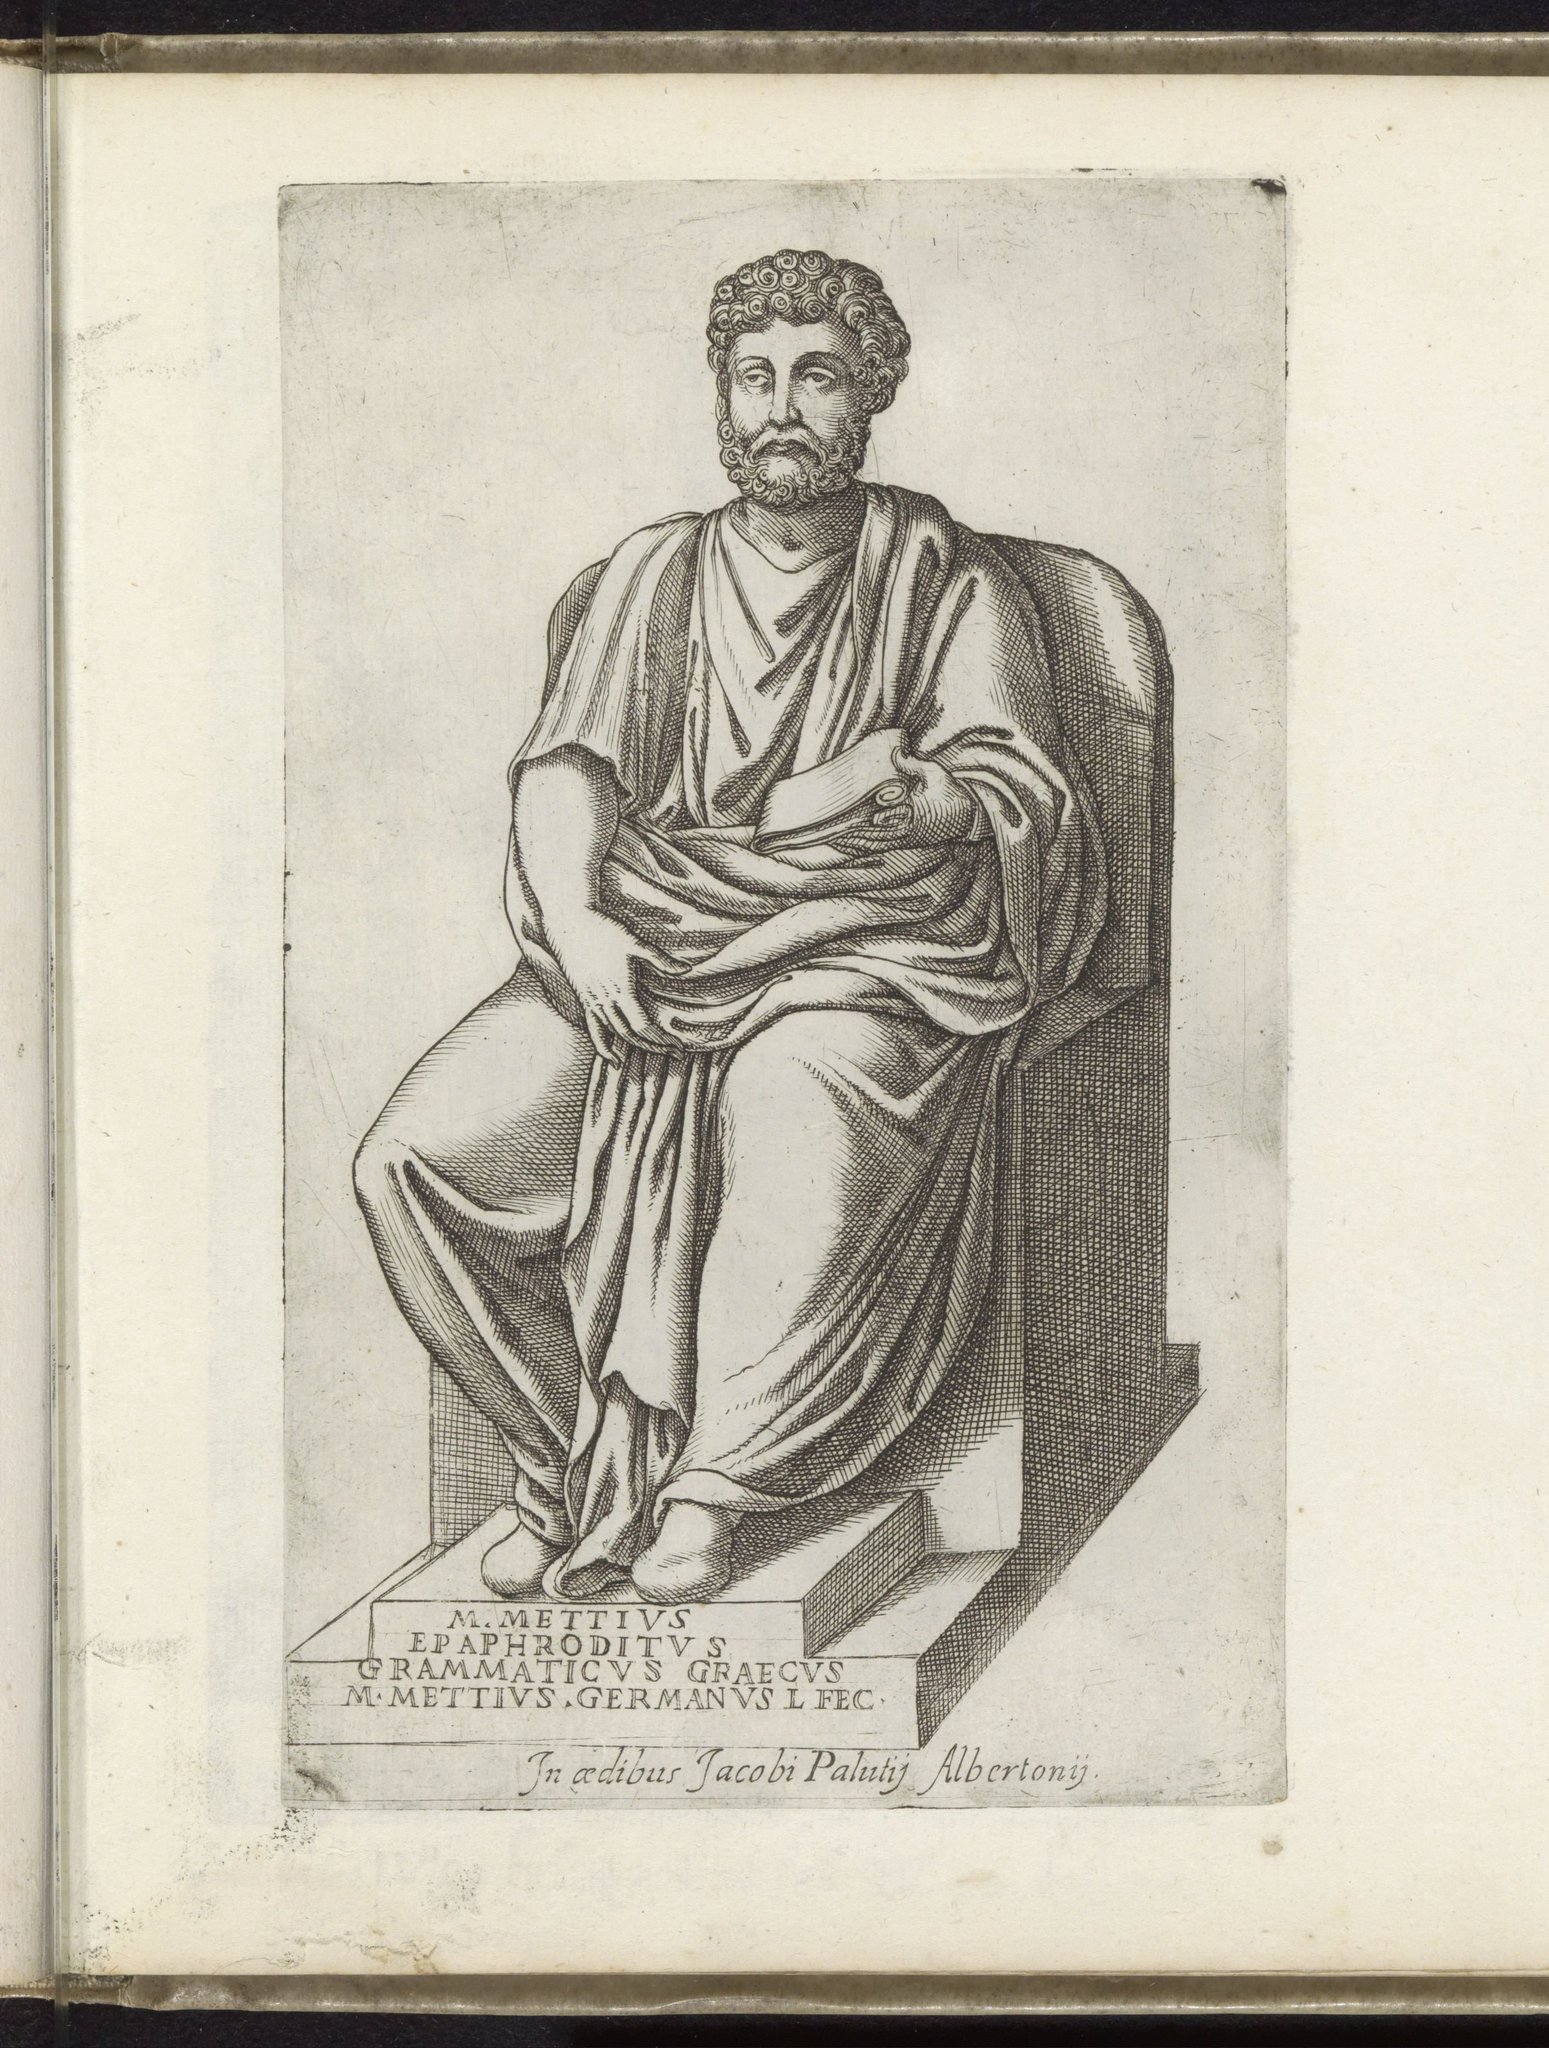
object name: album leaf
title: Sculpturen uit de oudheid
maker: Anonymous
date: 1600-1699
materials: paper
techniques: engraving, etching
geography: italy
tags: historical persons, piece of sculpture, reproduction of a piece of sculpture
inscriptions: number: ‘79’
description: Deze prent maakt deel uit van een reeks van ten minste 50 prenten van sculpturen uit de oudheid.